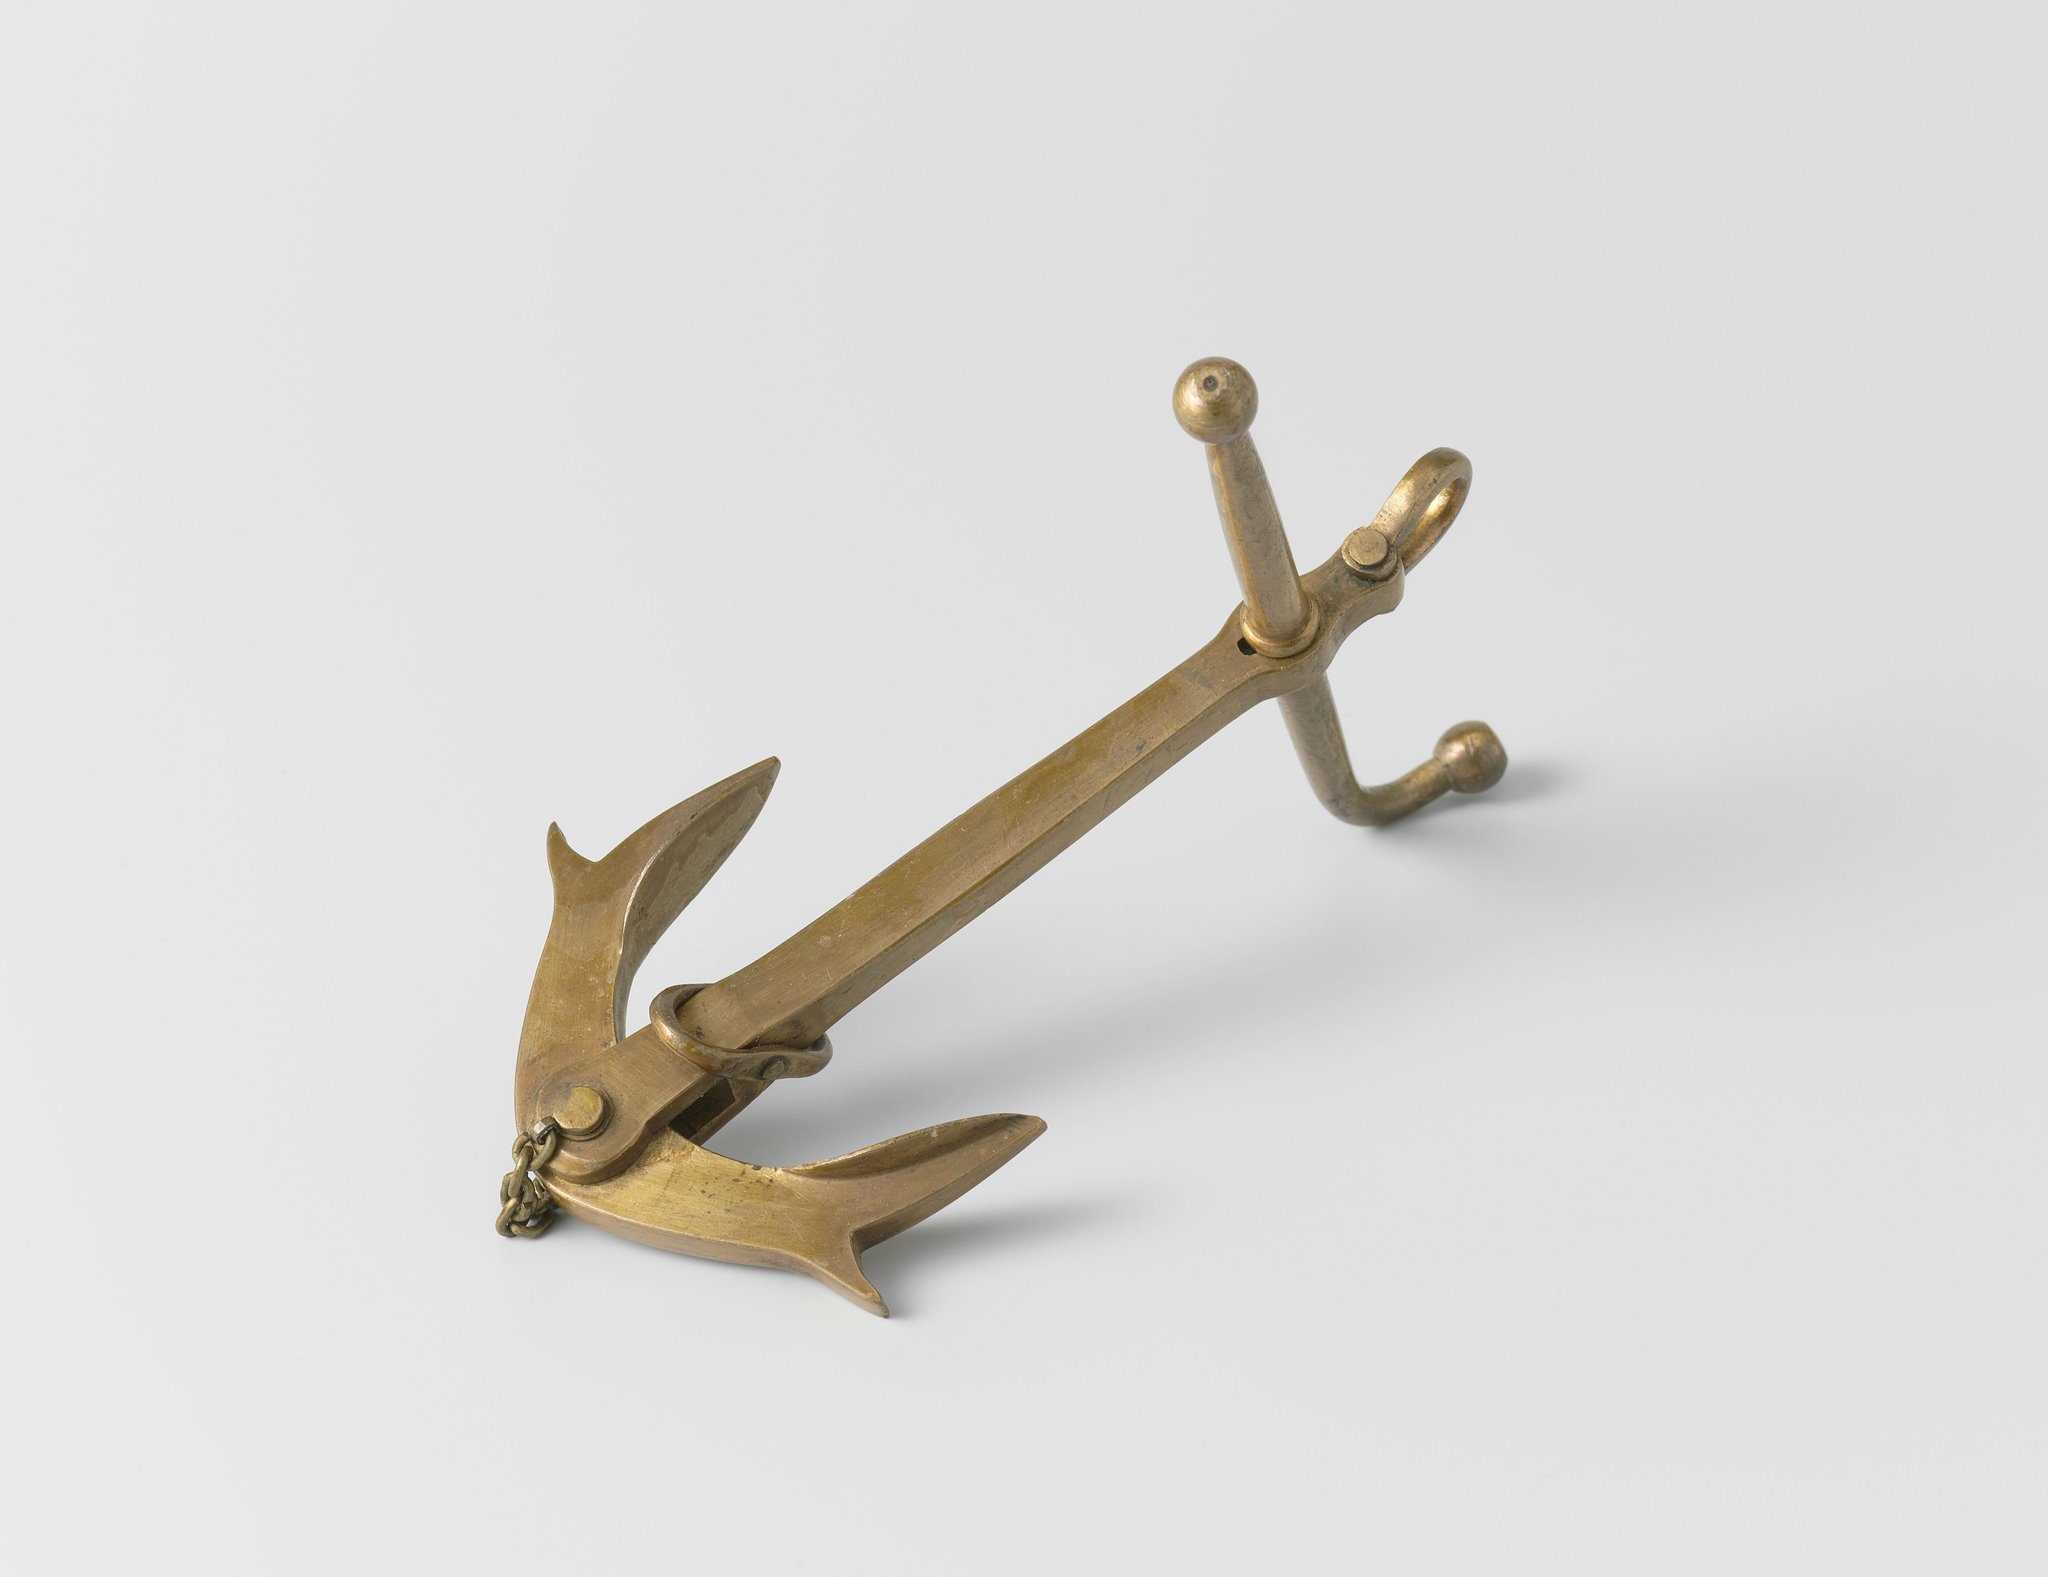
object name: demonstration model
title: Model of an Anchor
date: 1845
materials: brass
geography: united kingdom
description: Model van het stokanker van Porter. De armen draaien om een as in het gevorkte eind van de schacht; de hoek van de armen is kleiner dan gewoonlijk en de handen zijn voorzien van een hoorn aan de buitenkant. De ankerstok kan door het gat van de schacht geschoven worden en parallel aan de schacht. Aan het uiteinden van de schacht zit een harp, bij het kruis een ketting en om de schacht heen een dubbele schalm. Schaal 1:10 (schatting).